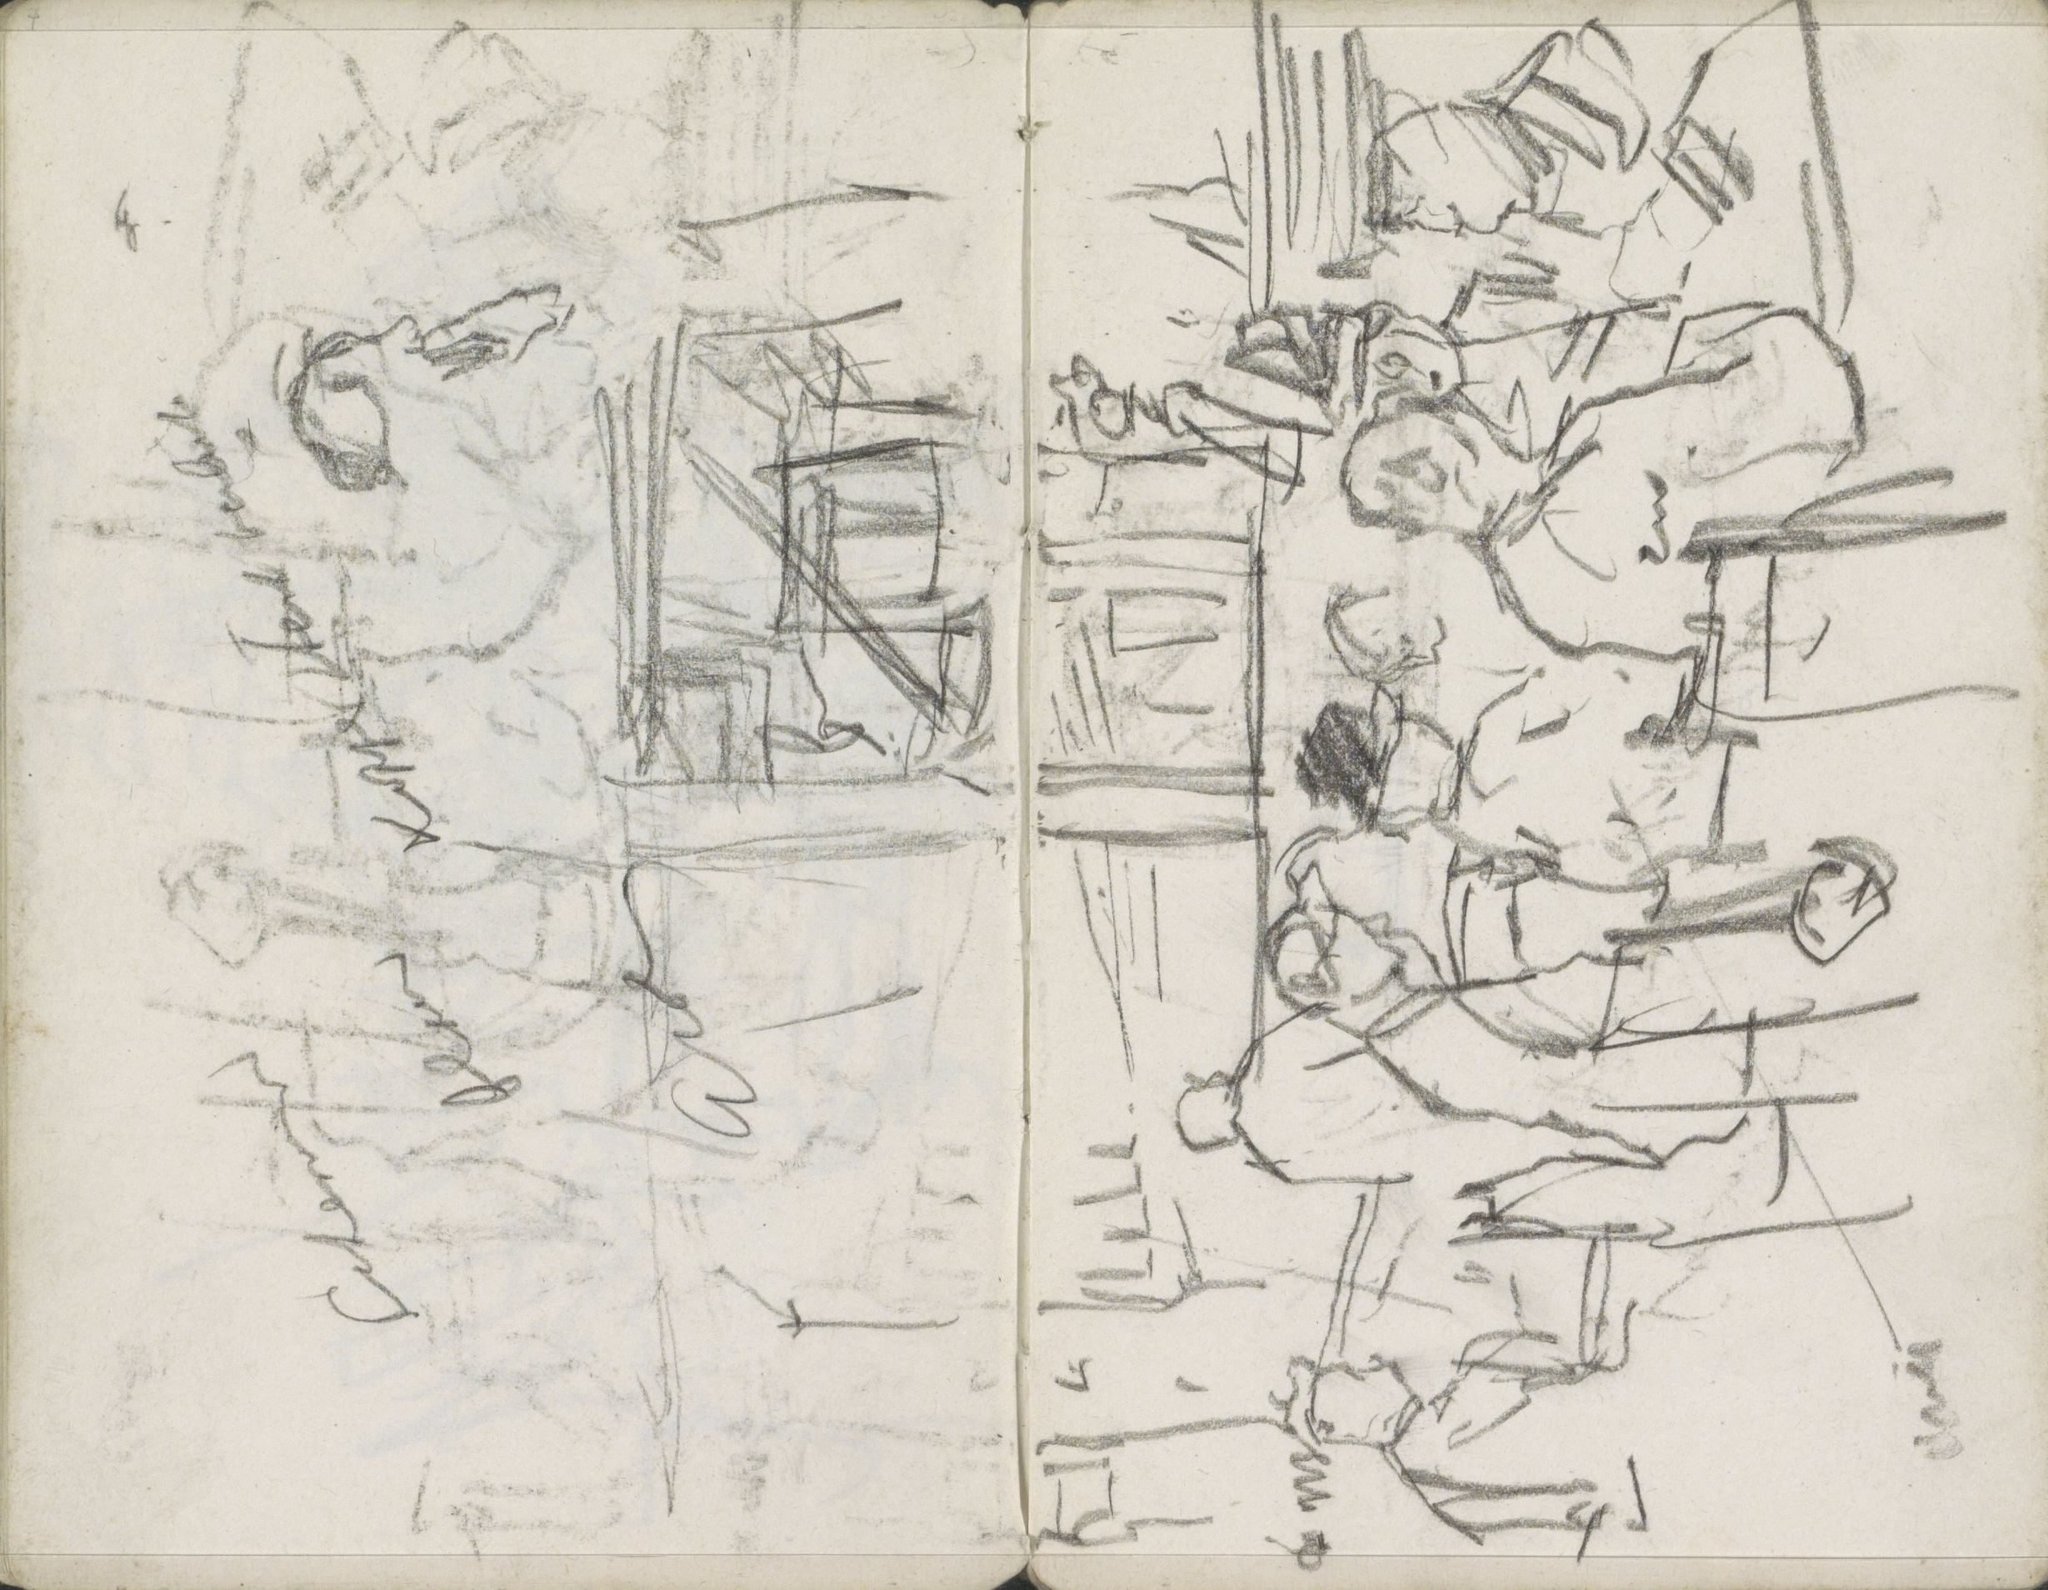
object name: sketchbook leaf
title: Figuren in een etablissement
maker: george hendrik breitner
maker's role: draughtsman, painter, print maker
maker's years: 1857-1923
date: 1917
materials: chalk, paper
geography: amsterdam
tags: inn, coffee-house, public house, etc., amsterdam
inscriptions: annotation: ‘Schemer/ Koppen sterk verlicht’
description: Pagina 7 en pagina 8 uit een schetsboek met 44 bladen.